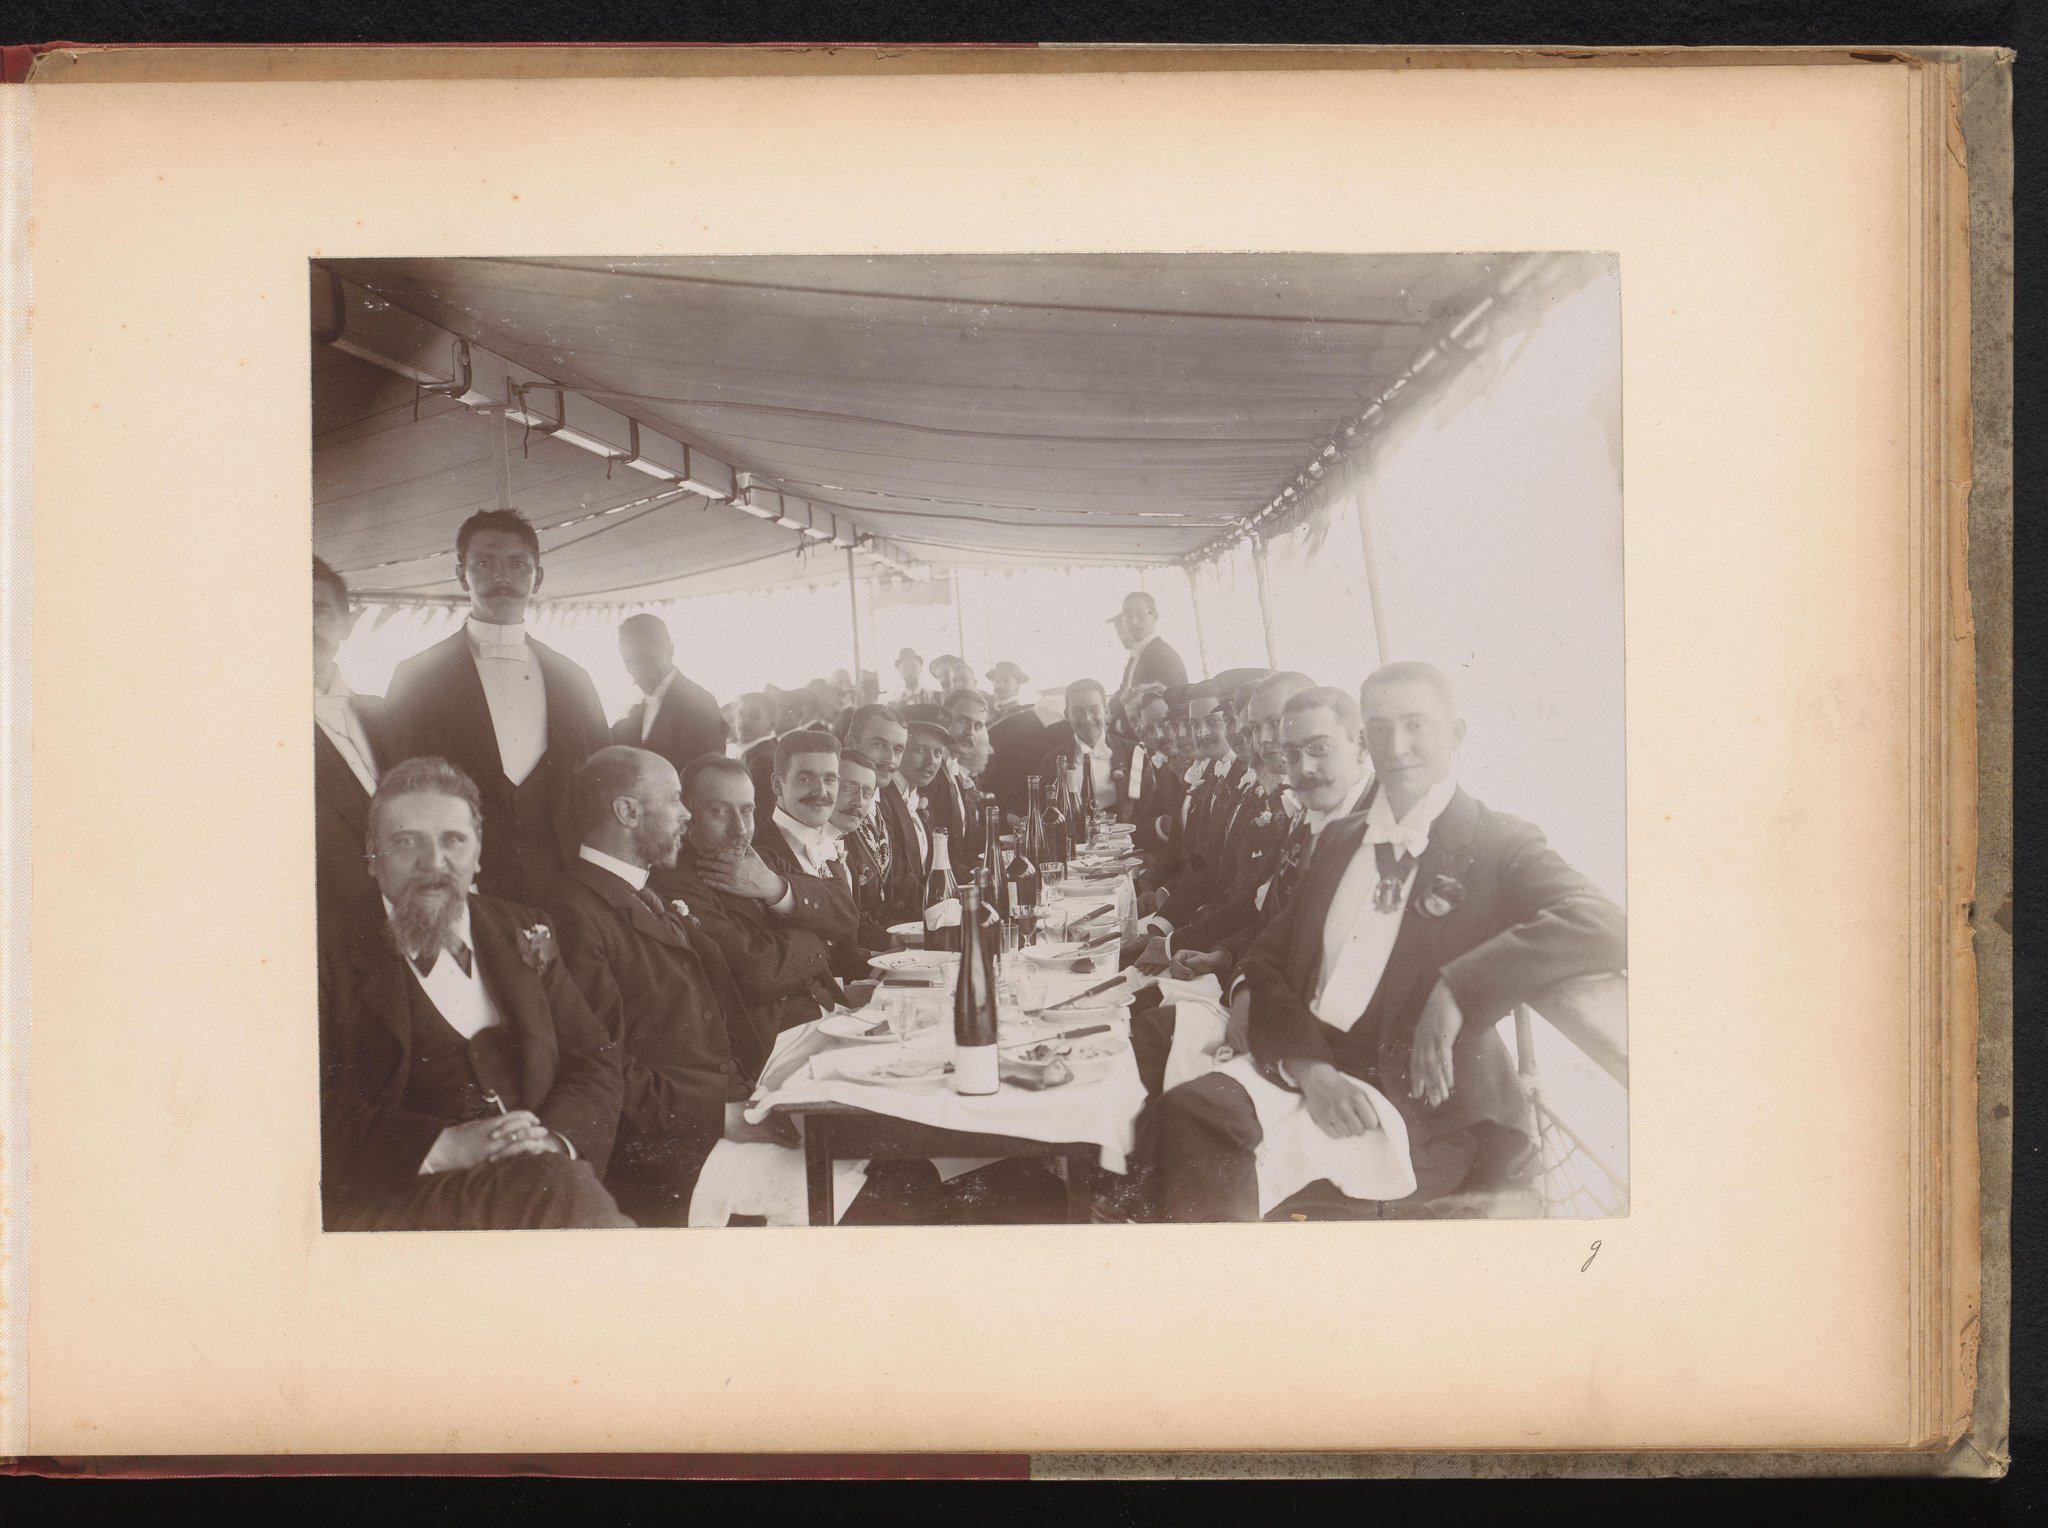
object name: photograph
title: Groep leden van het Amsterdamsch Studenten Corps aan tafel op een rondvaartboot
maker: nicolaas schuitvlot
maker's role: fotograaf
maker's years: 1859-1947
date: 1806-1897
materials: cardboard, photographic support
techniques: collodion silver print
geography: netherlands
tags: passenger liner, students' organization, adult man (+ more than eight persons), laid table: table-ware, table-decoration, etc., netherlands